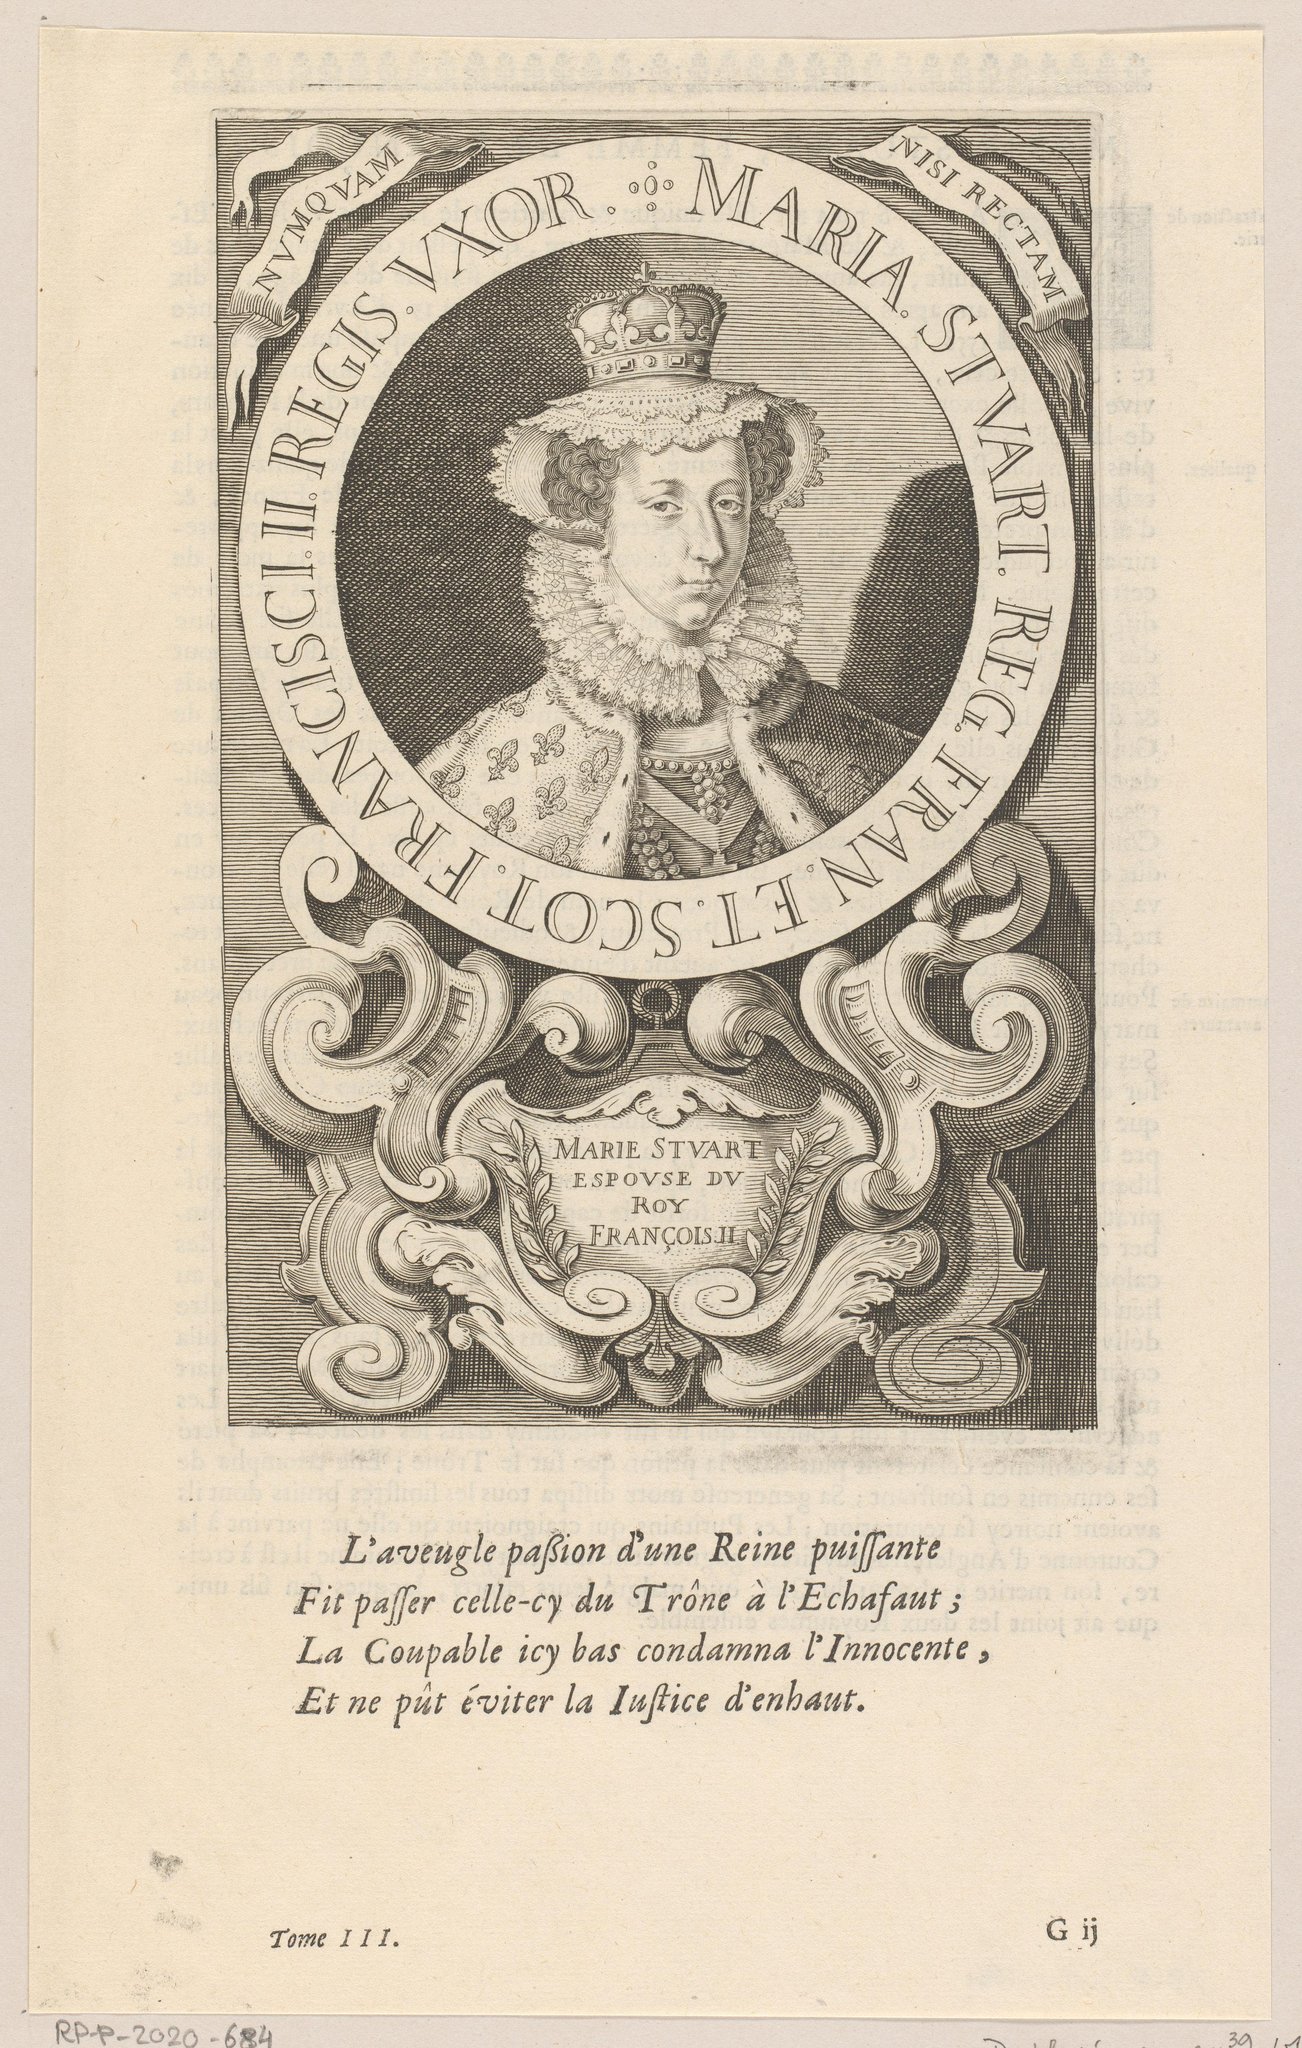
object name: print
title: Portret van Maria I Stuart, koningin van Schotland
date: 1635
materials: paper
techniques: engraving, letterpress printing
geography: paris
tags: historical persons - bb - woman, queen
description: Prent uit: Eudes de Mézeray, François. Histoire de France, depuis Faramond jusqu’au regne de Louis le Juste (...). 3 dln. Parijs: Denis Thierry, Jean Guignard en Claude Barbin, 1635, dl. 3. Prent waarschijnlijk voor het eerst verschenen in: Bie, Jacques de. Les vrais portraits des rois de France (...). Parijs: Jacques de Bie en Pierre Rocolet, 1634. Prent ook gebruikt in latere publicaties.